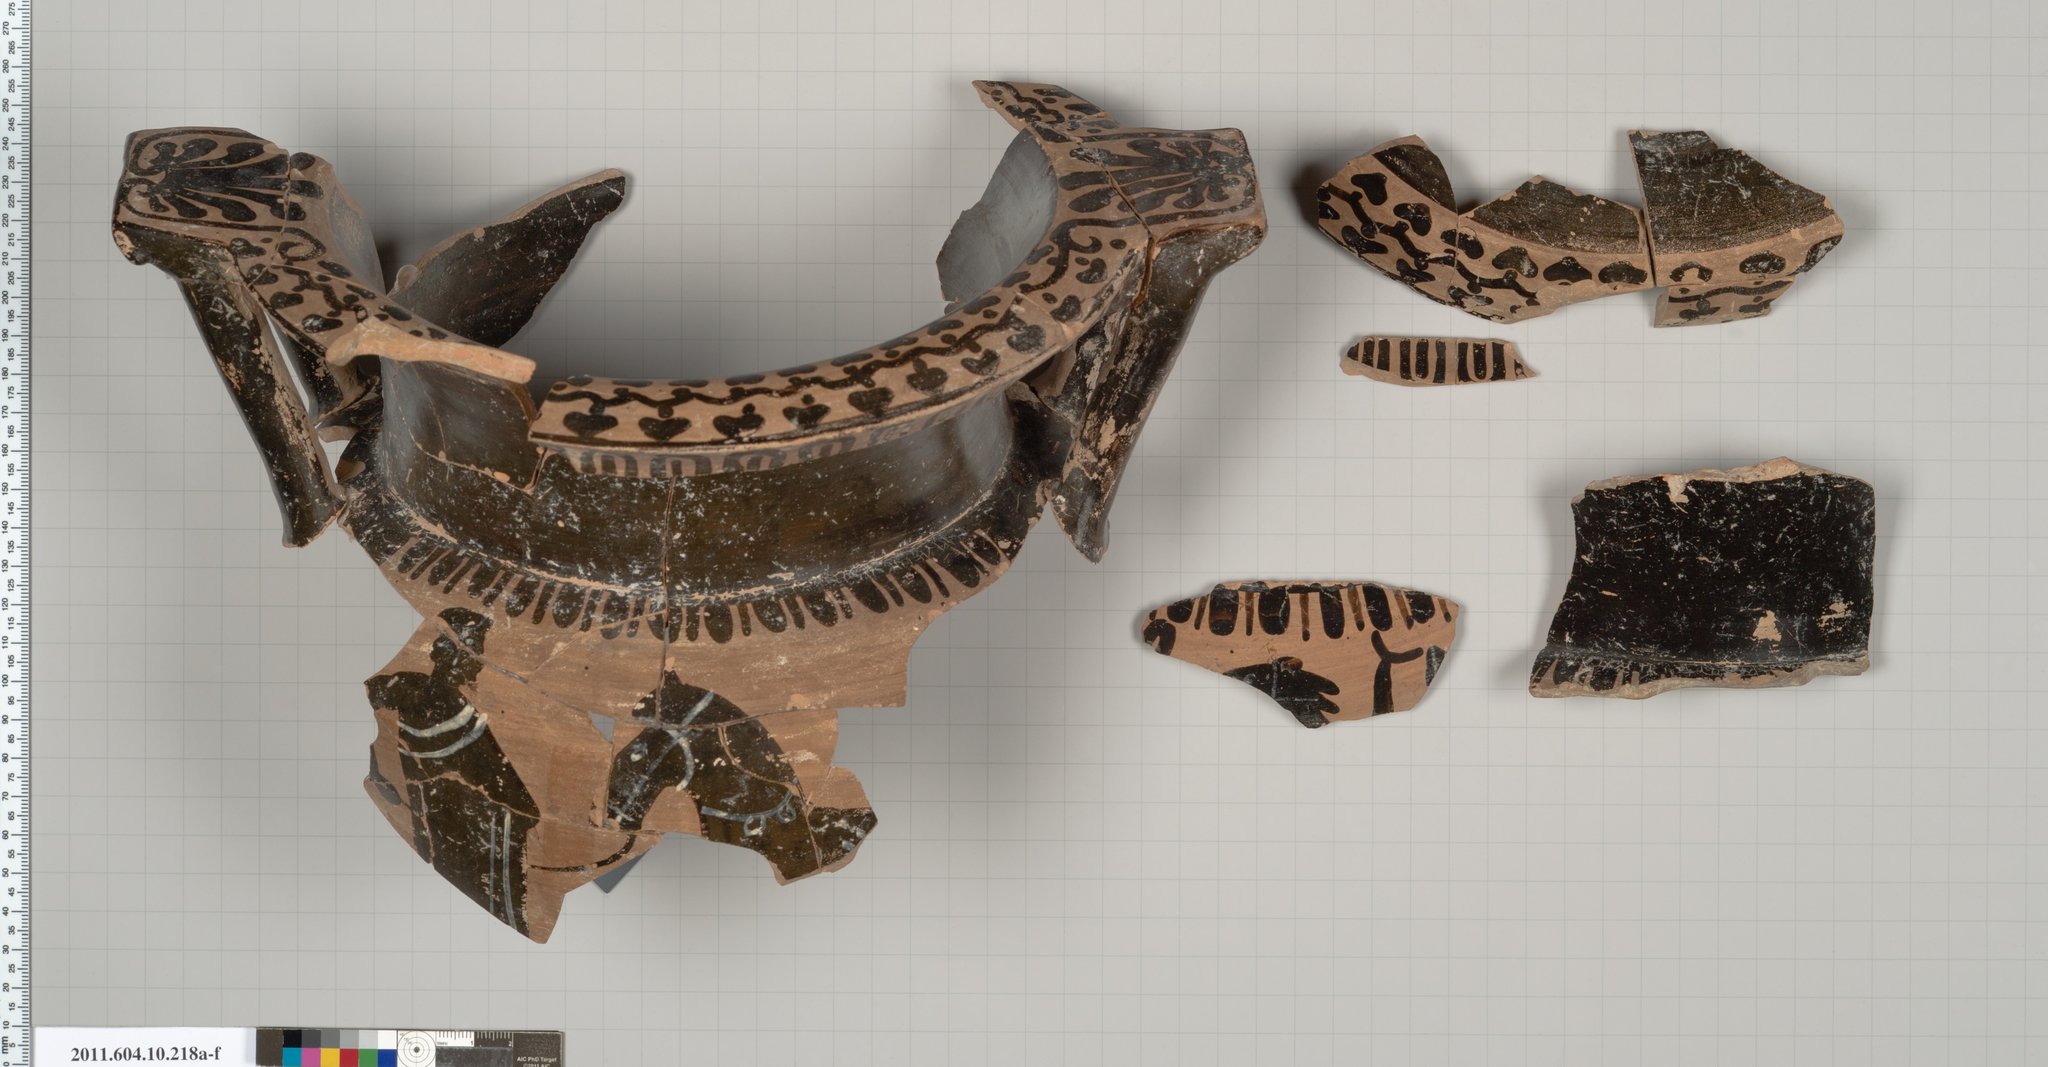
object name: column krater fragment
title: Terracotta fragments of a column-krater (deep bowl)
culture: etruscan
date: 500-480 BCE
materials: terracotta